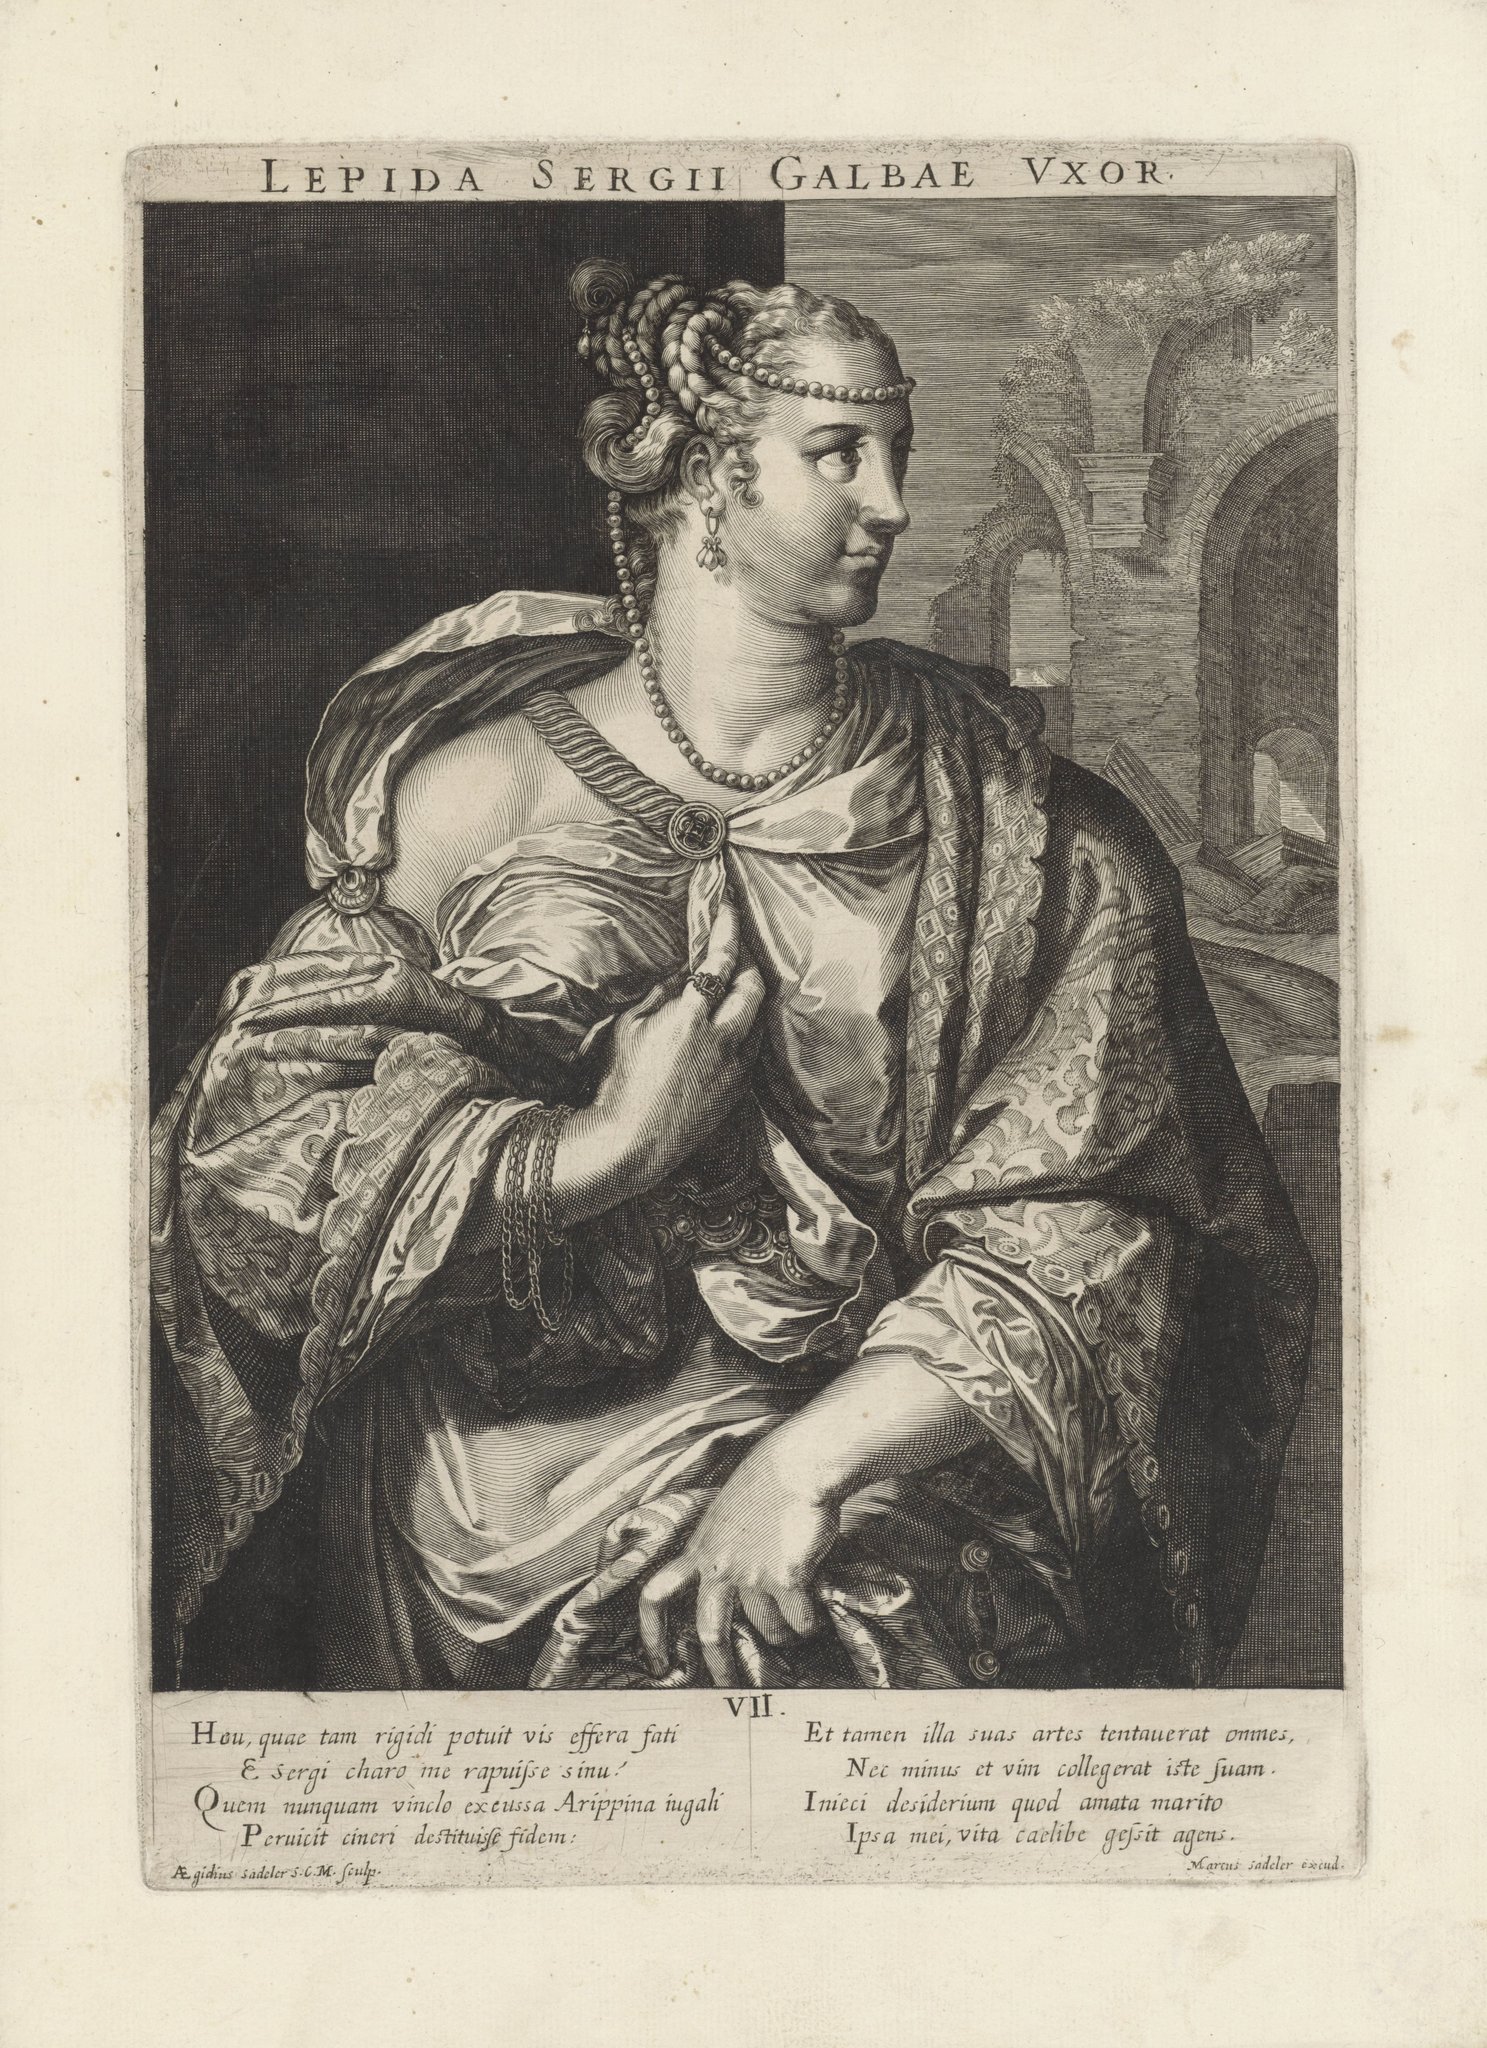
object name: print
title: Beroemde Romeinse vrouwen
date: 1597-1629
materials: paper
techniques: engraving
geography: prague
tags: aemilia lepida (1e eeuw)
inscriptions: collector's mark: Lugt 240